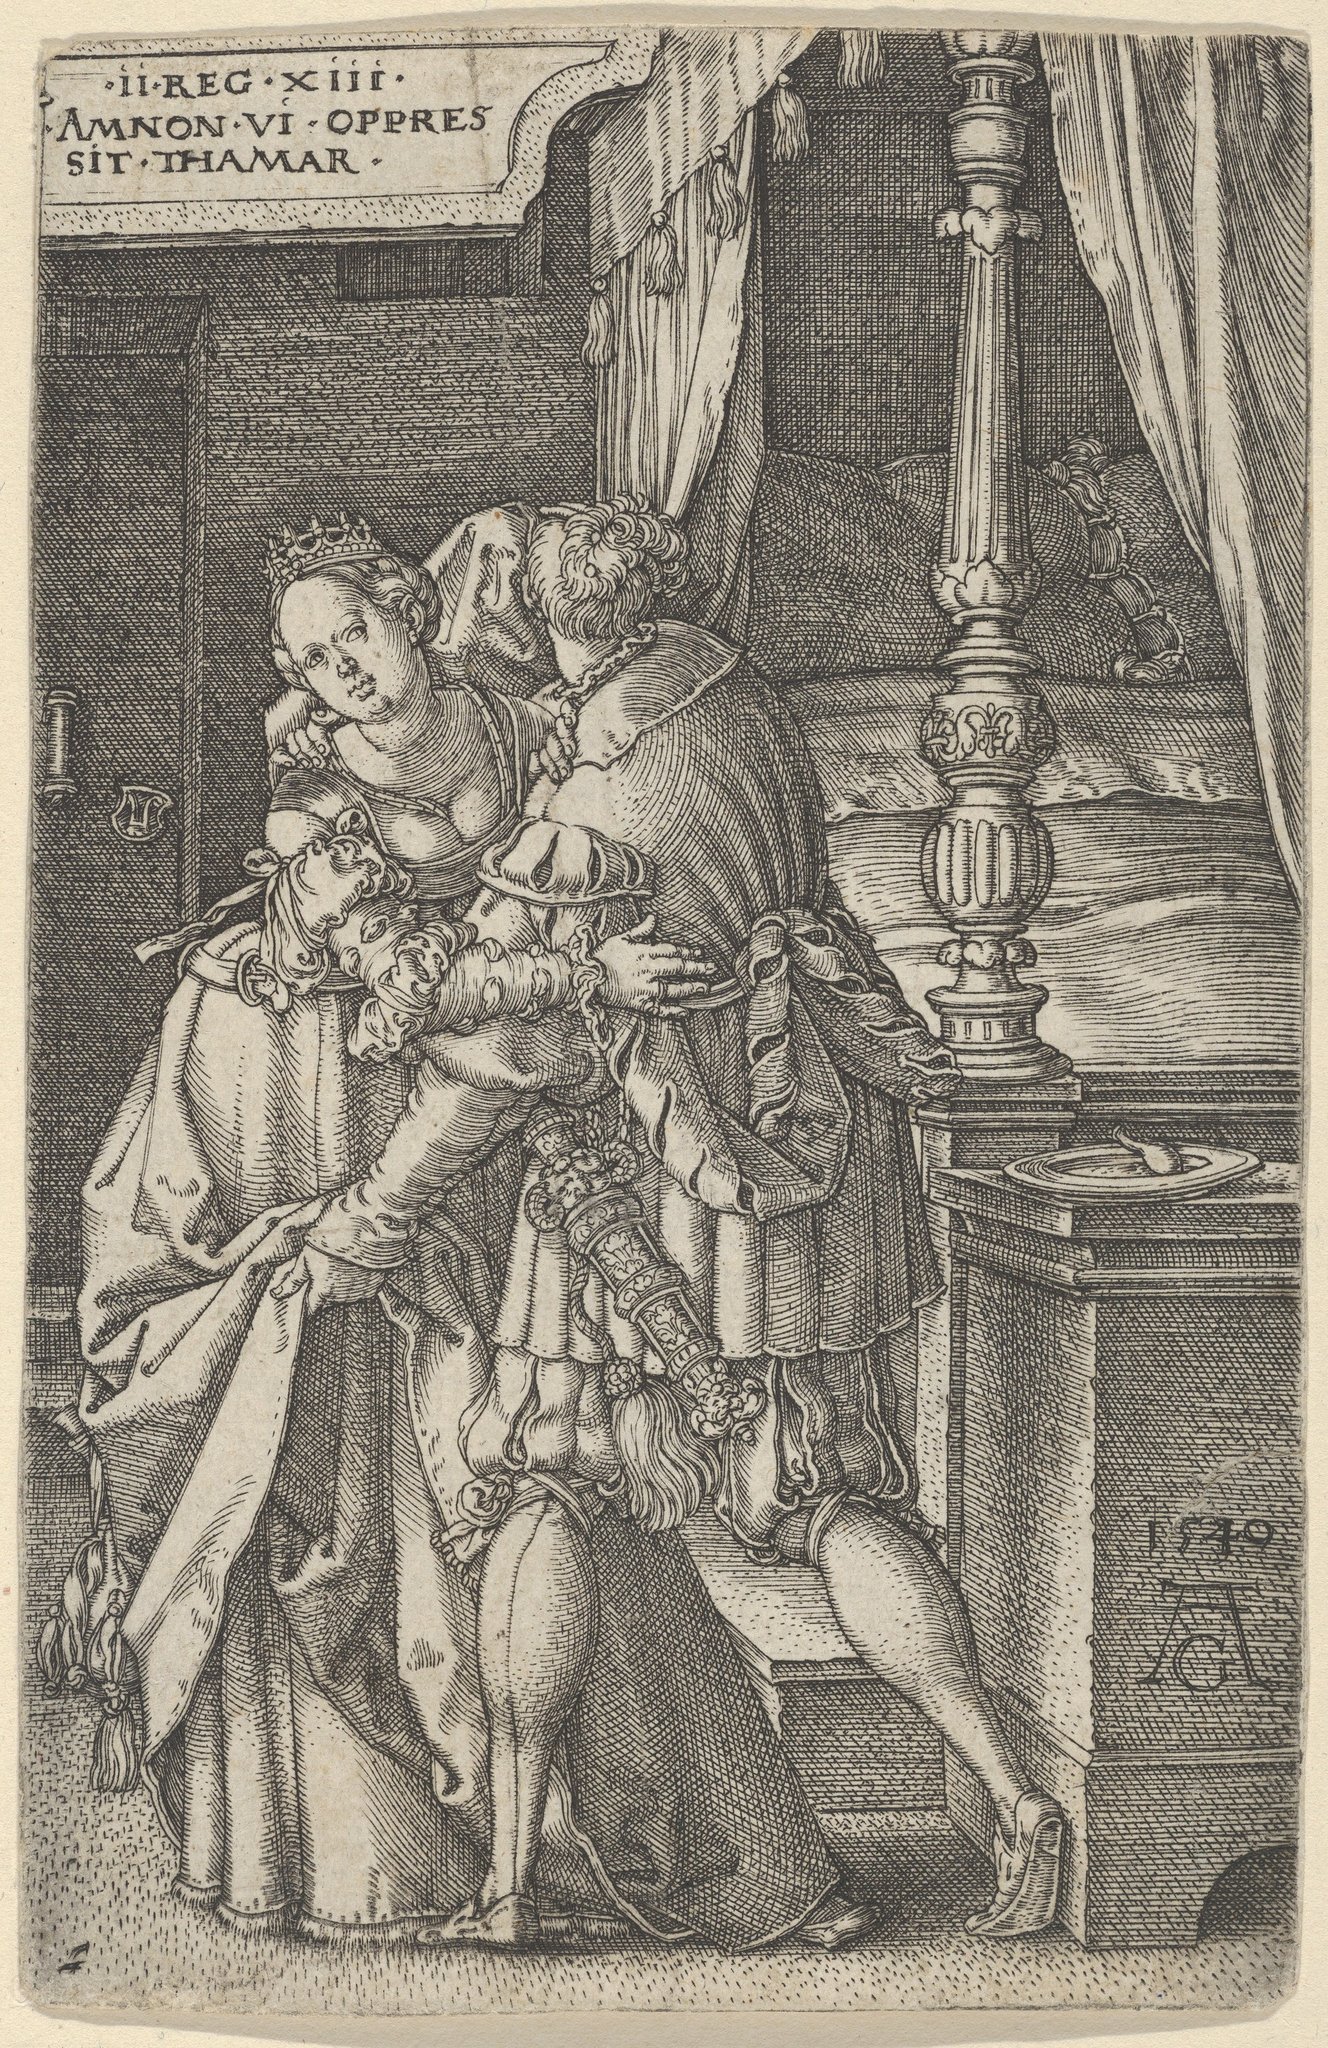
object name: print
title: Amnon Violating Tamar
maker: heinrich aldegrever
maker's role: artist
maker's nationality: german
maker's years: 1502-1561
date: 1540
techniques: engraving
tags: bedrooms,men,women